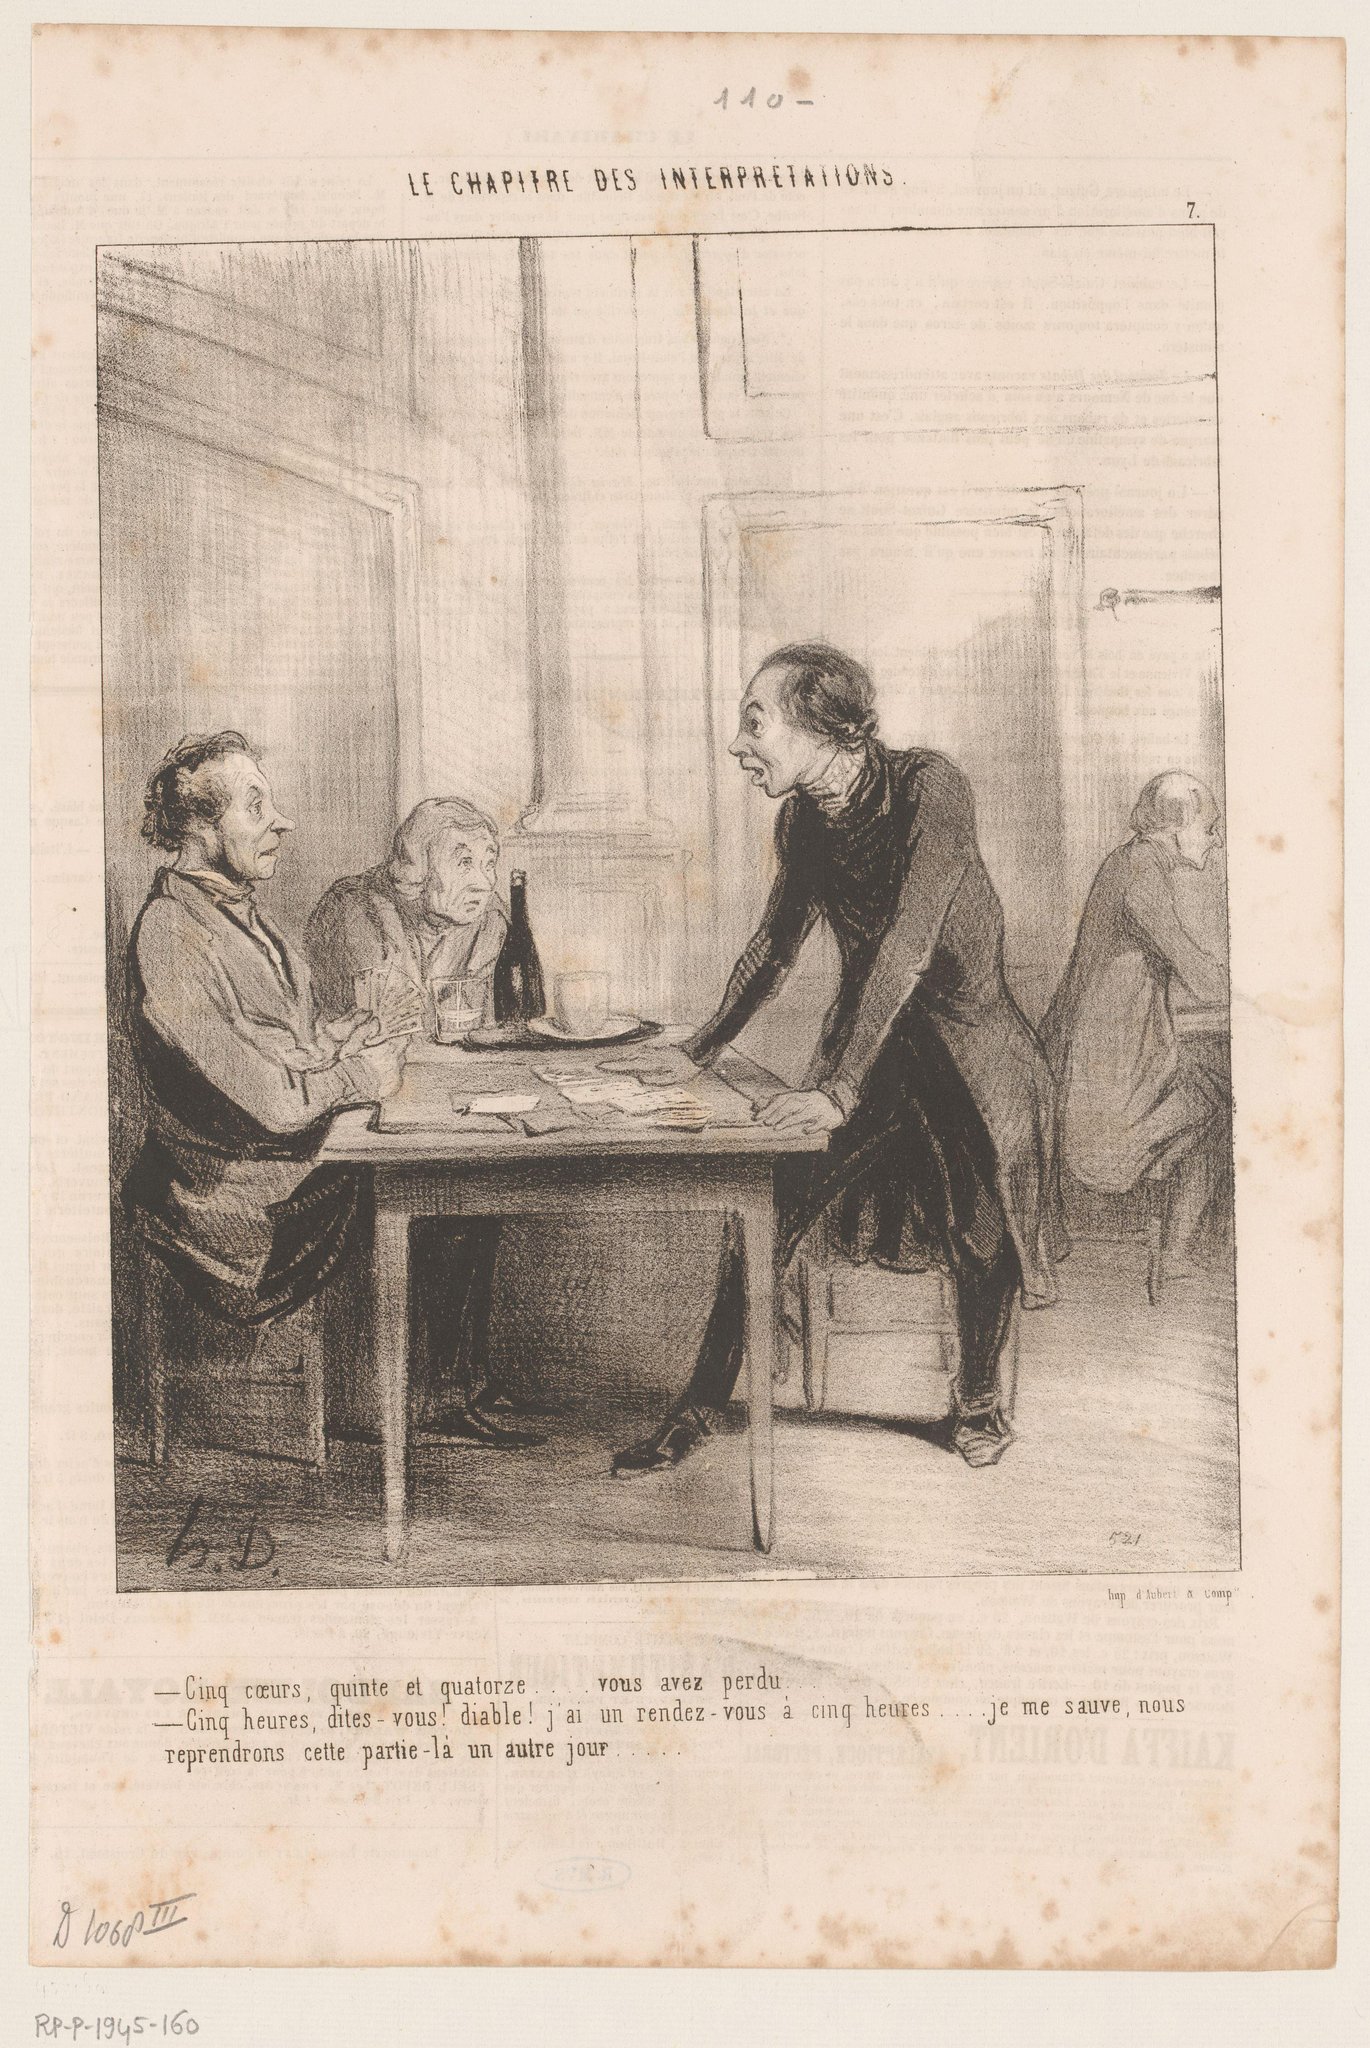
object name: cartoon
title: Miscommunicatie in het café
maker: honoré daumier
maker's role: draughtsman, painter, print maker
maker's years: 1808-1879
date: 1843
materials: paper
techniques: lithograph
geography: paris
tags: caricatures (human types), misunderstanding, inn, coffee-house, public house, etc., playing-cards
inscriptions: number: ‘110’, collector's mark: Lugt 2228a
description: Twee mannen zijn aan het kaarten in een café. De linkerman zegt tegen de ander dat hij verloren heeft, en noemt 'cinq coeurs' (vijf harten). De andere man staat meteen op: hij zegt dat hij een afspraak heeft om 'cinq heures' (vijf uur).